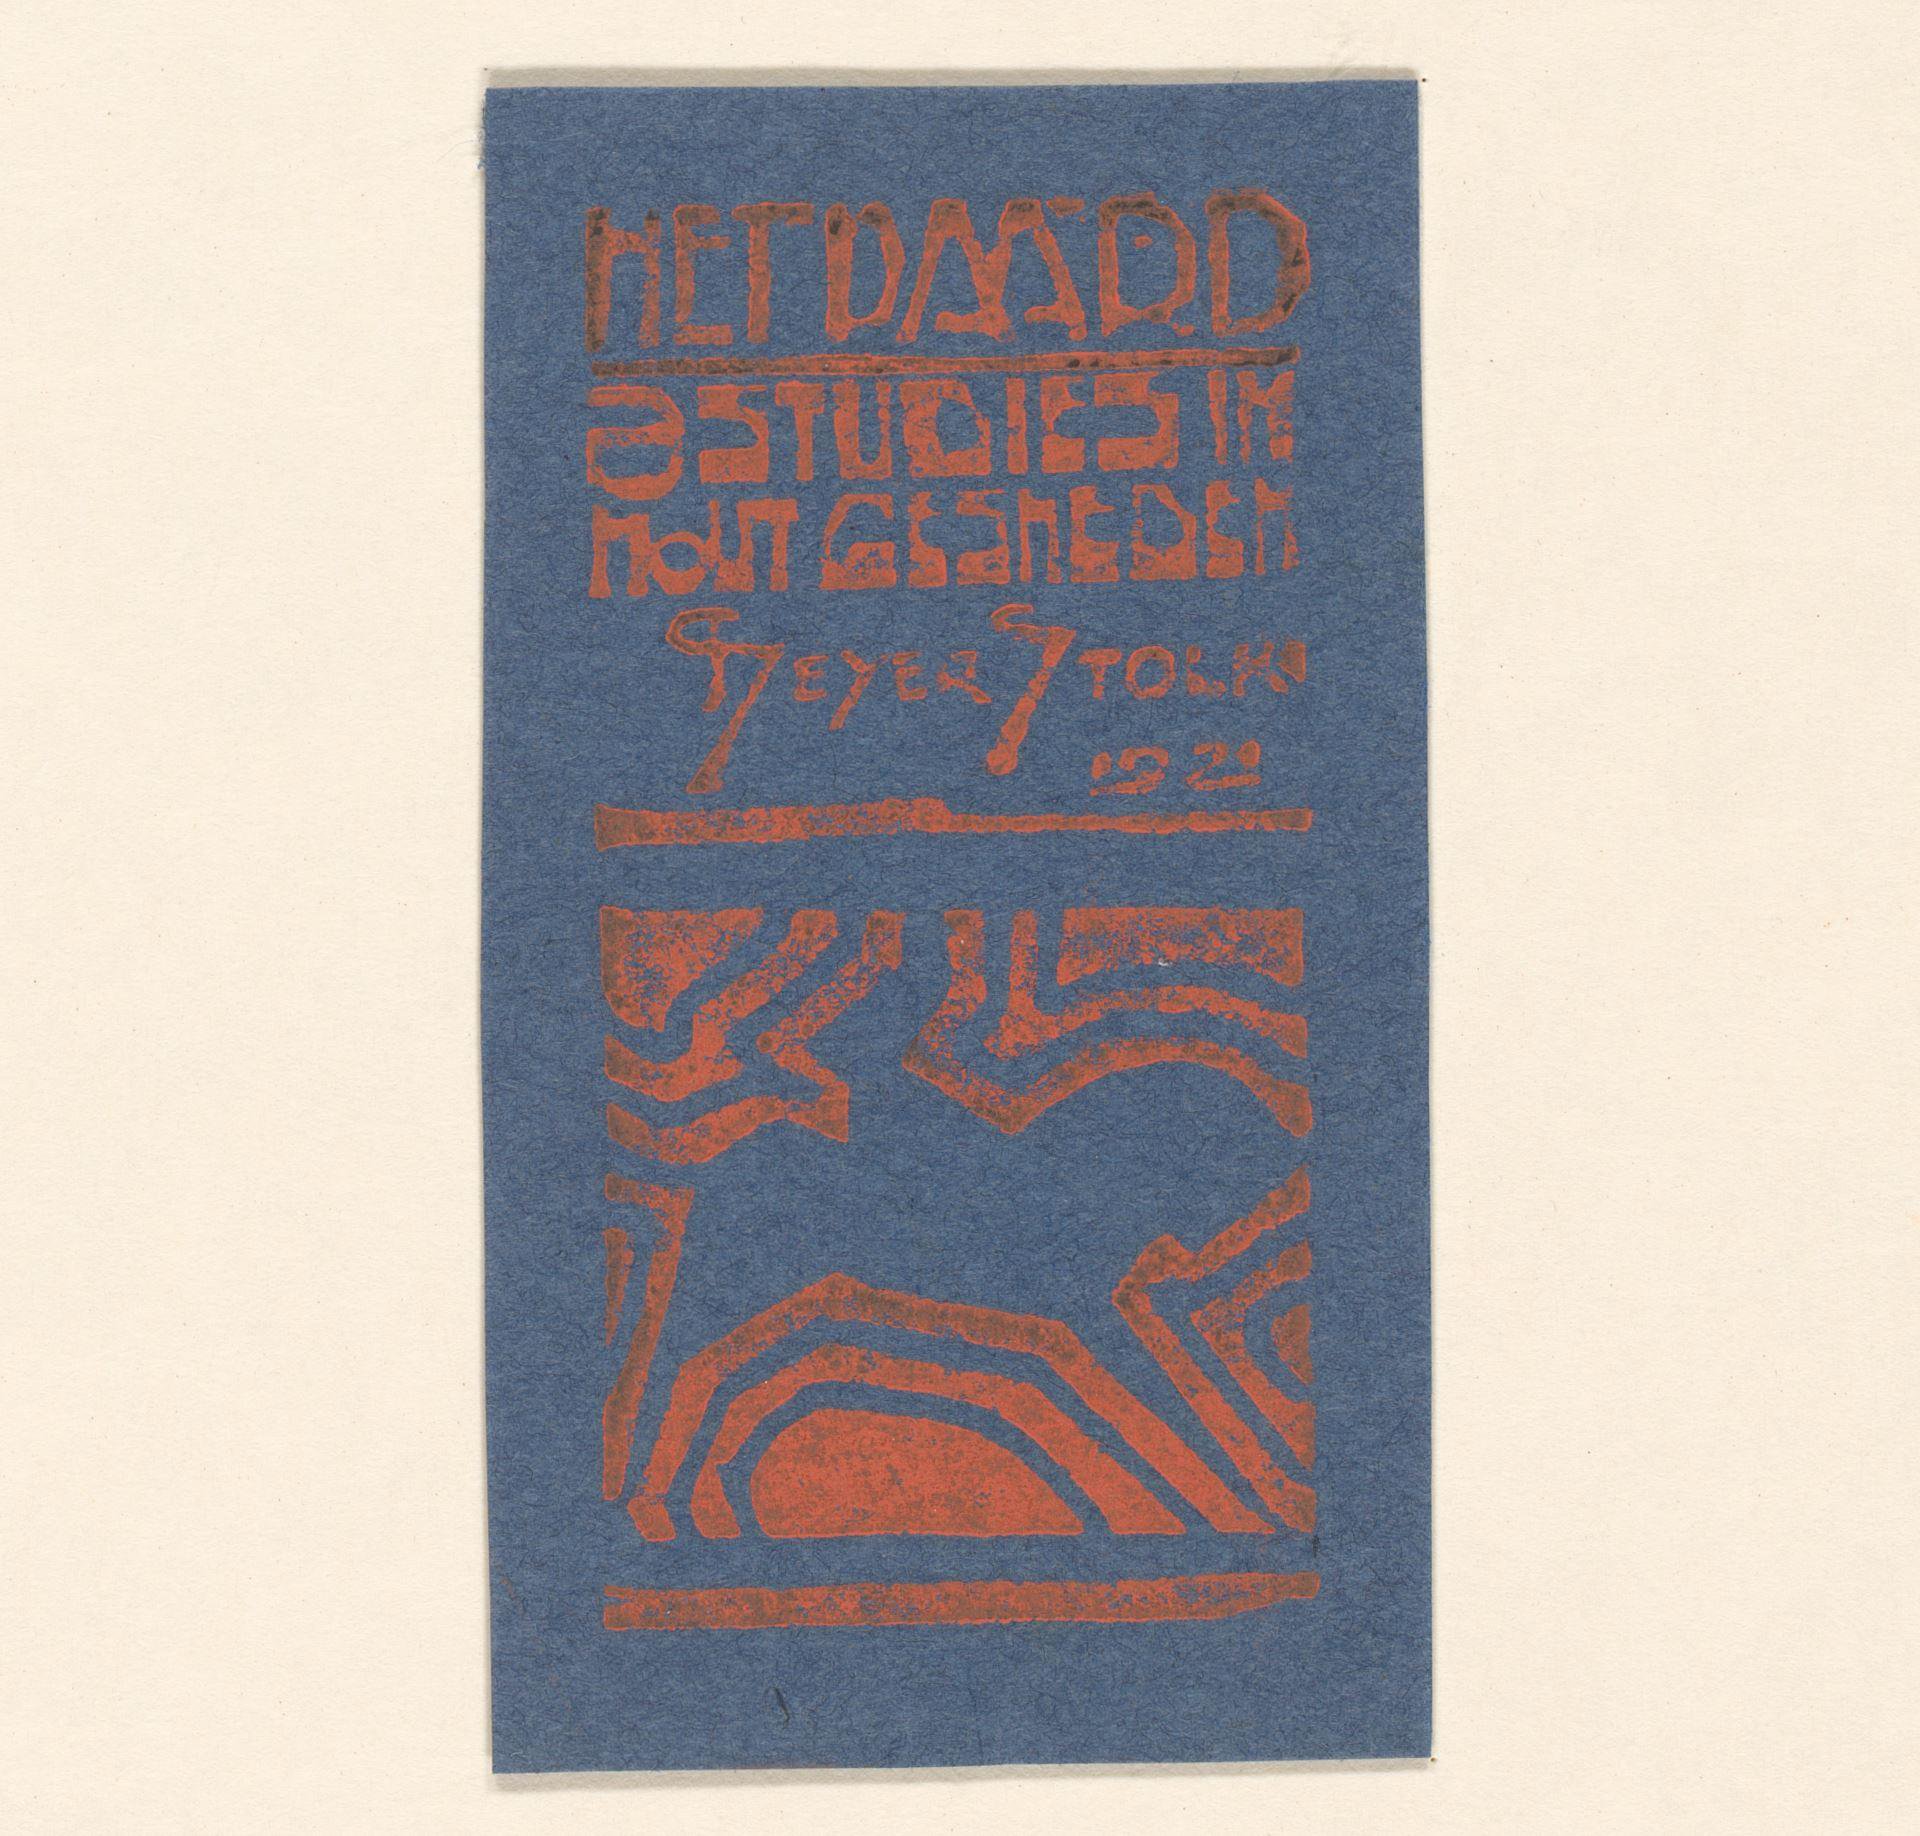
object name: print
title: Het paard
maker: reijer stolk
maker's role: draughtsman, print maker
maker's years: 1896-1945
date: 1921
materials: paper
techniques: woodcut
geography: netherlands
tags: horse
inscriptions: collector's mark: Lugt 2760, collector's mark: Lugt 2228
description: Bovenaan de titel en ondertitel: 'Het paard 8 studies in hout gesneden'. Onderaan het silhouet van een ruiter te paard.